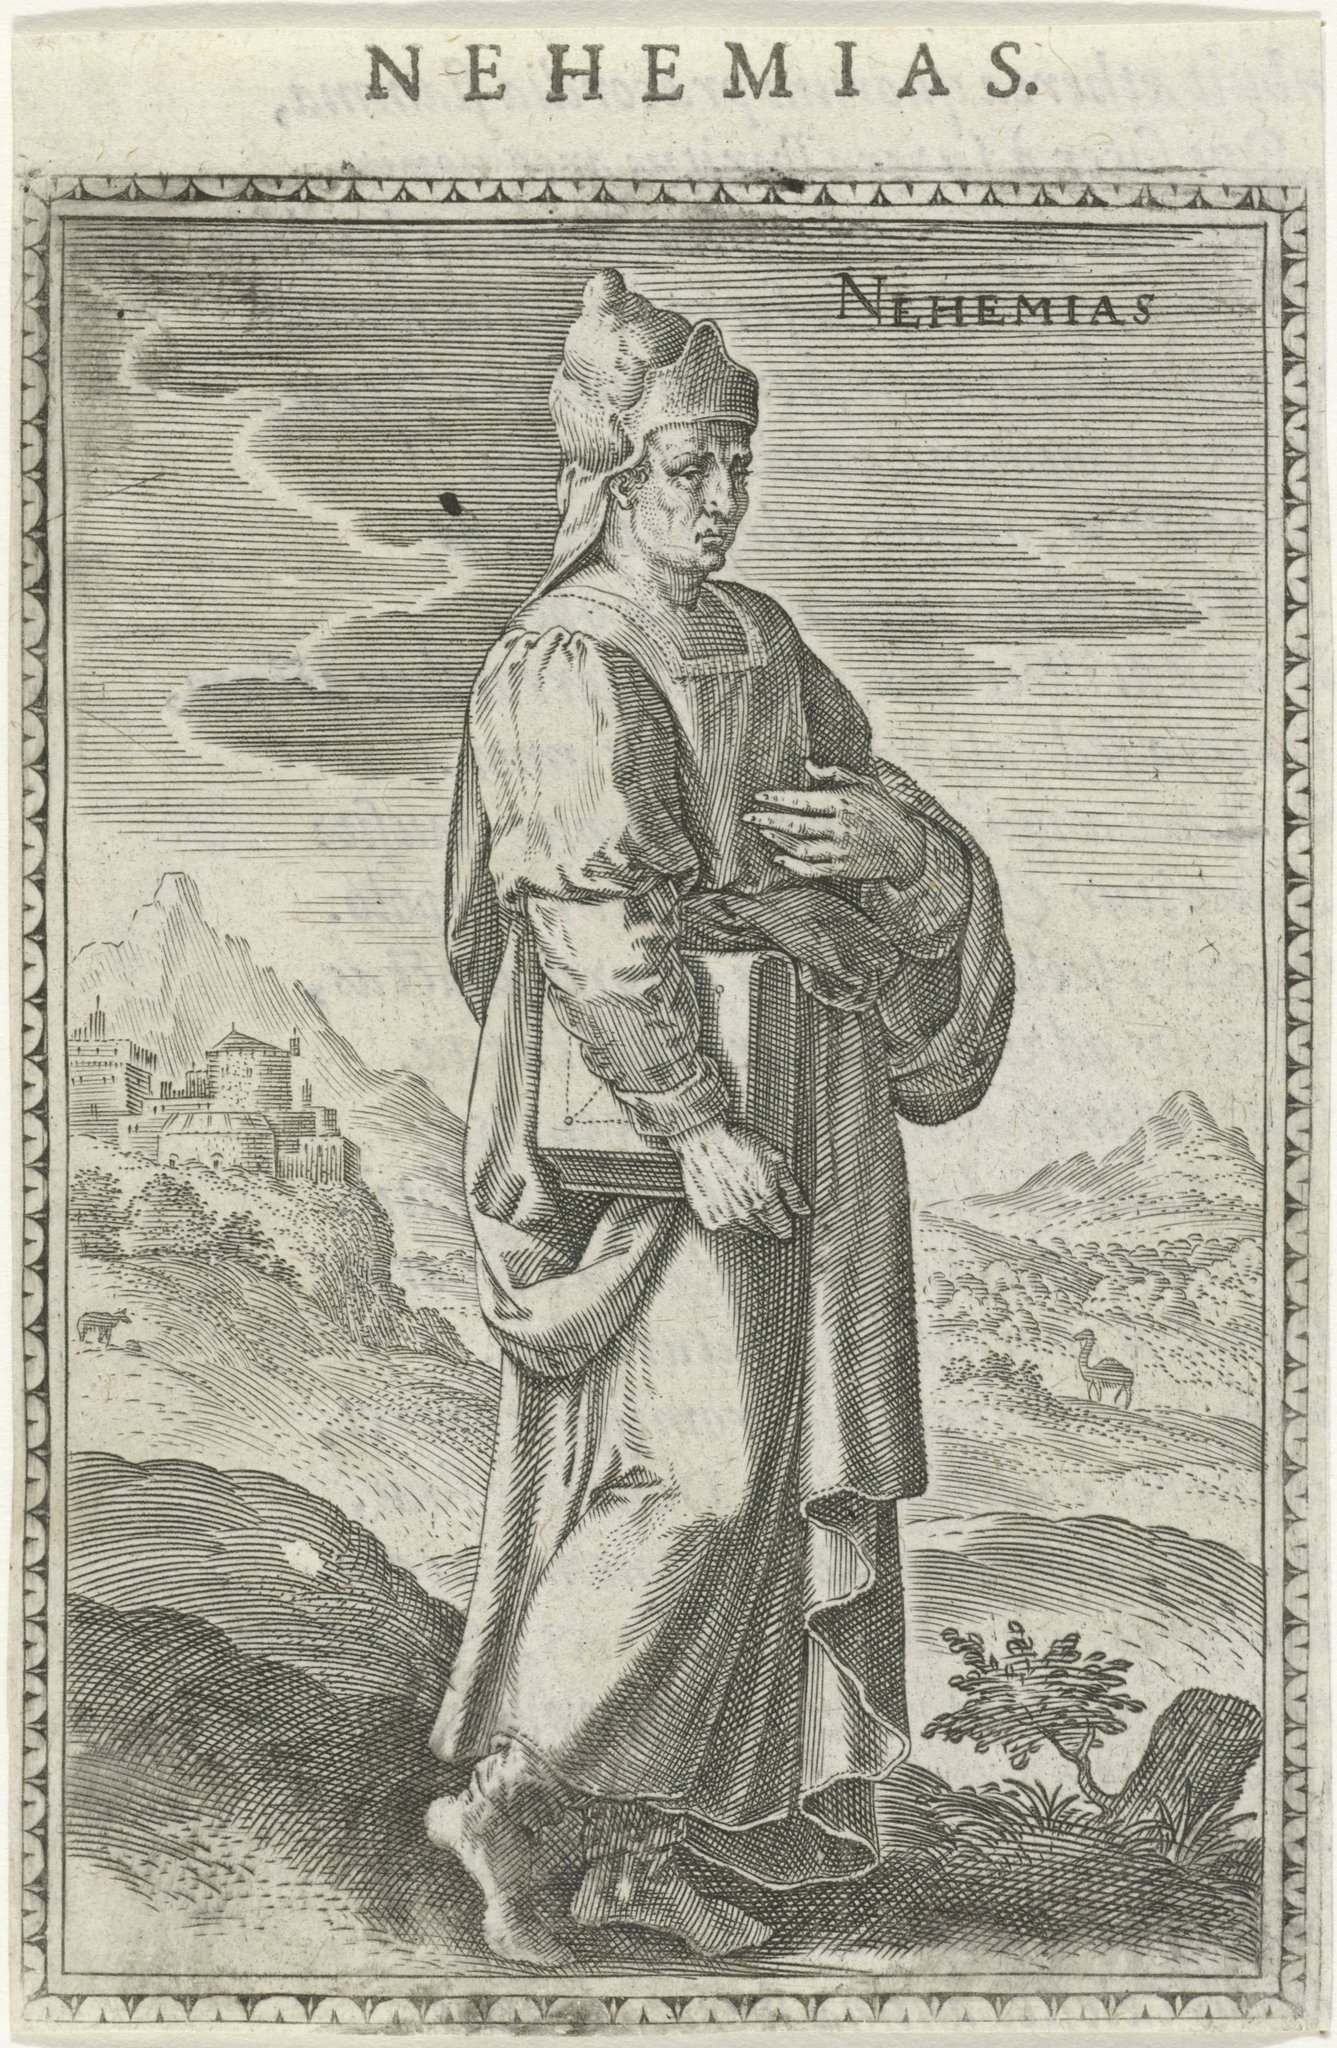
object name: book illustration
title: Nehemias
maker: johann sadeler (i)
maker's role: print maker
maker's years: 1550-1600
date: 1577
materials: paper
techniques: engraving, letterpress printing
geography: antwerp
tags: male persons from the old testament (with name) (not in biblical context)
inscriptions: collector's mark: Lugt 240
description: Boekillustratie voor Hillesem, Louis. Sacrarum antiquitatum monumenta. Antwerpen: Christoffel Plantin, 1577.